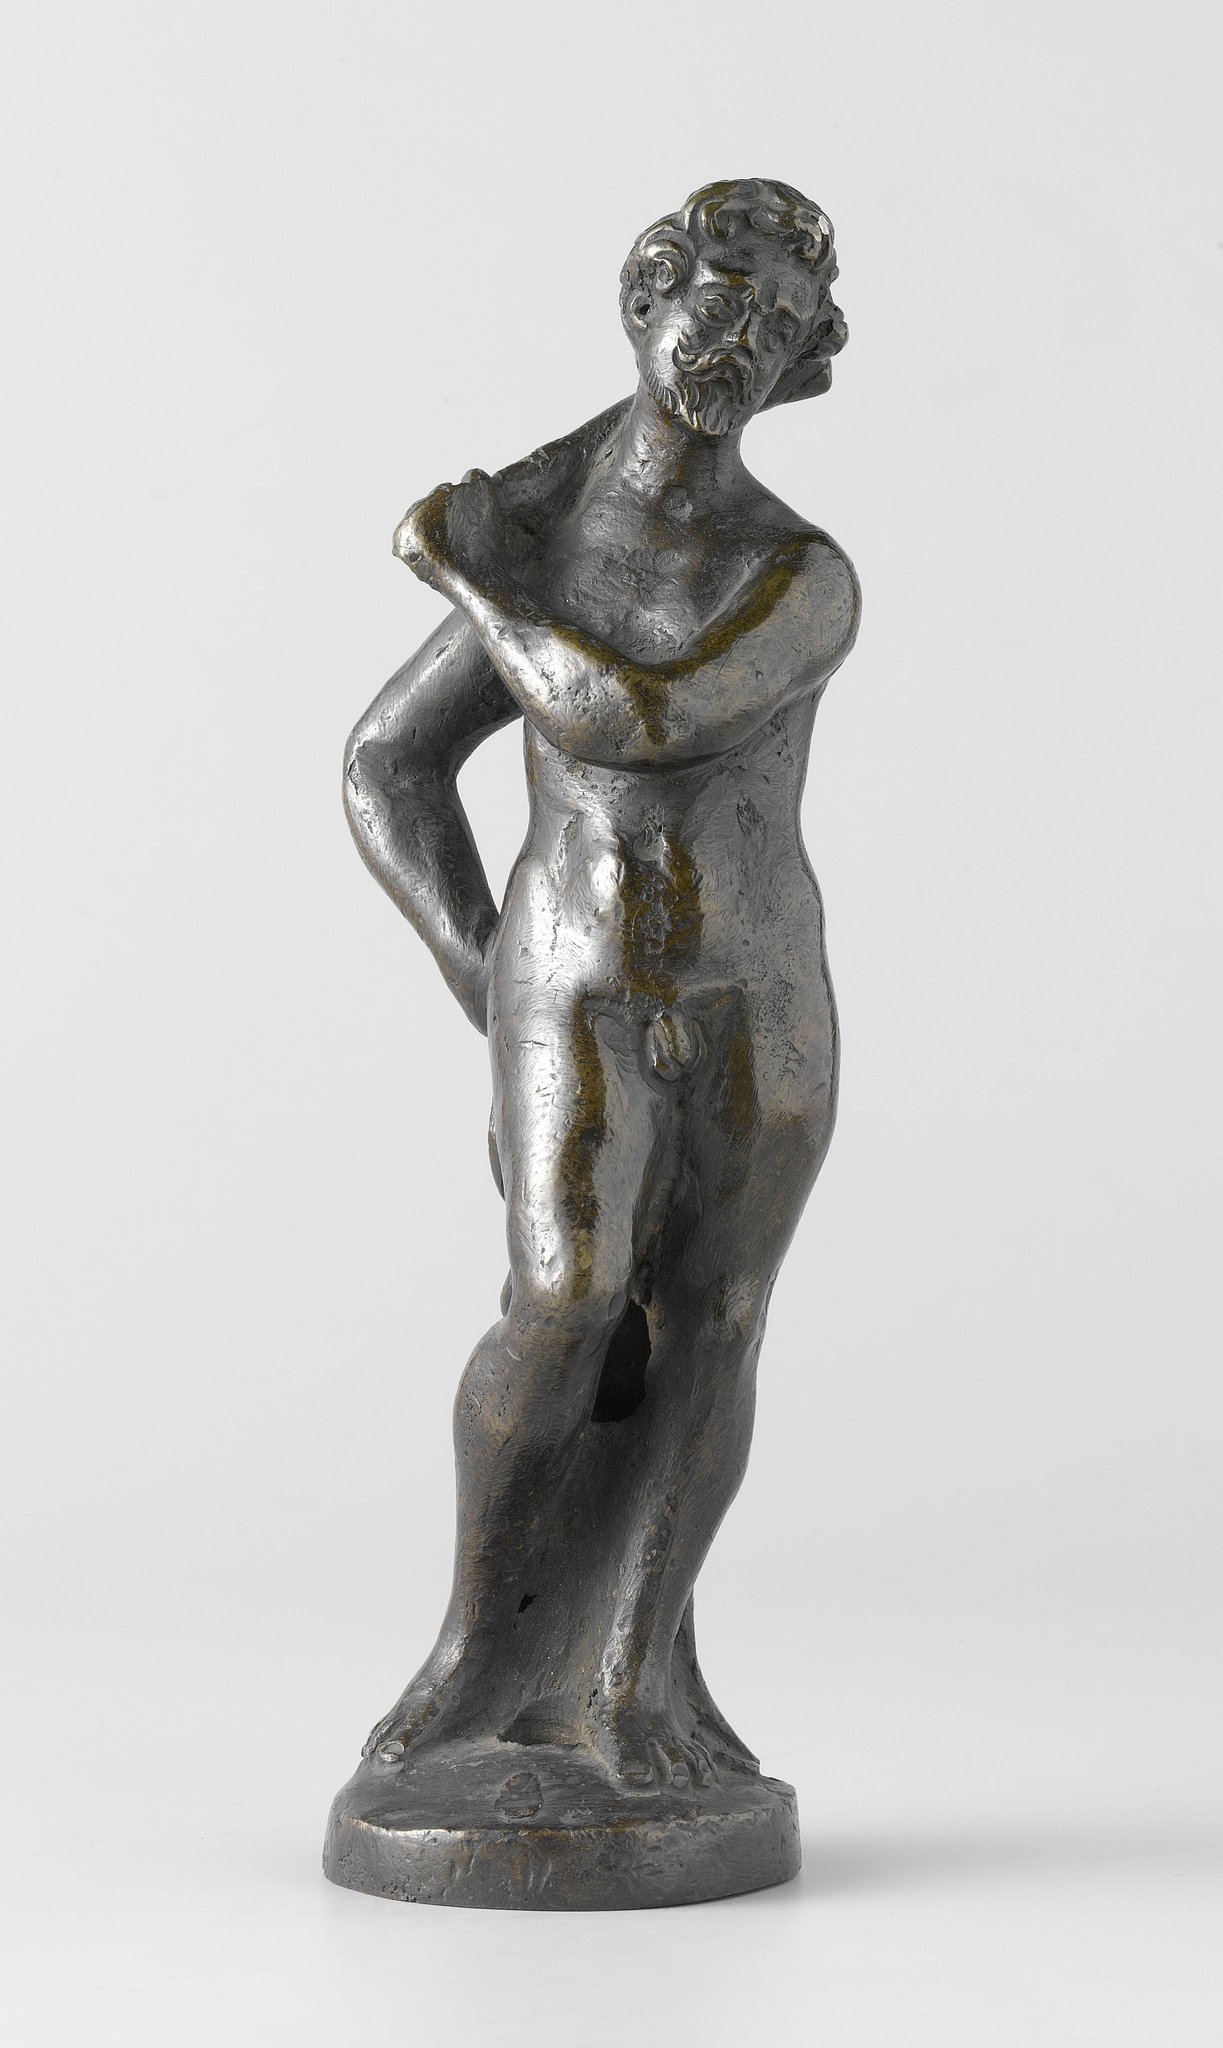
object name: sculpture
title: Mannenfiguur met knots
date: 1550-1600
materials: bronze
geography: venice